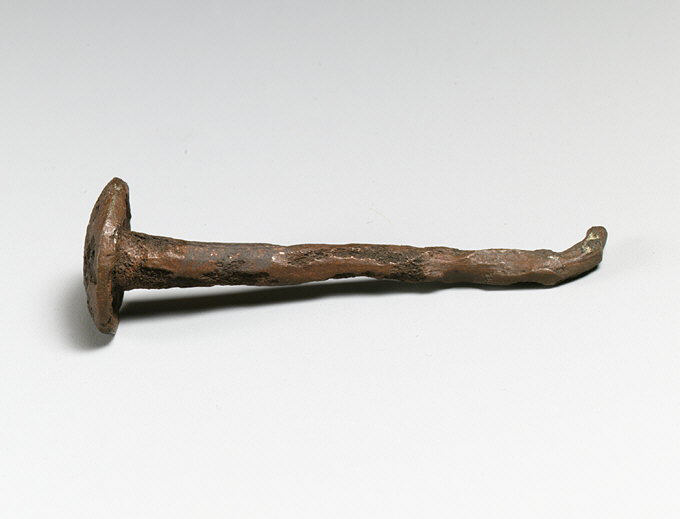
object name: nail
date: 7000 BCE-330 CE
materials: bronze